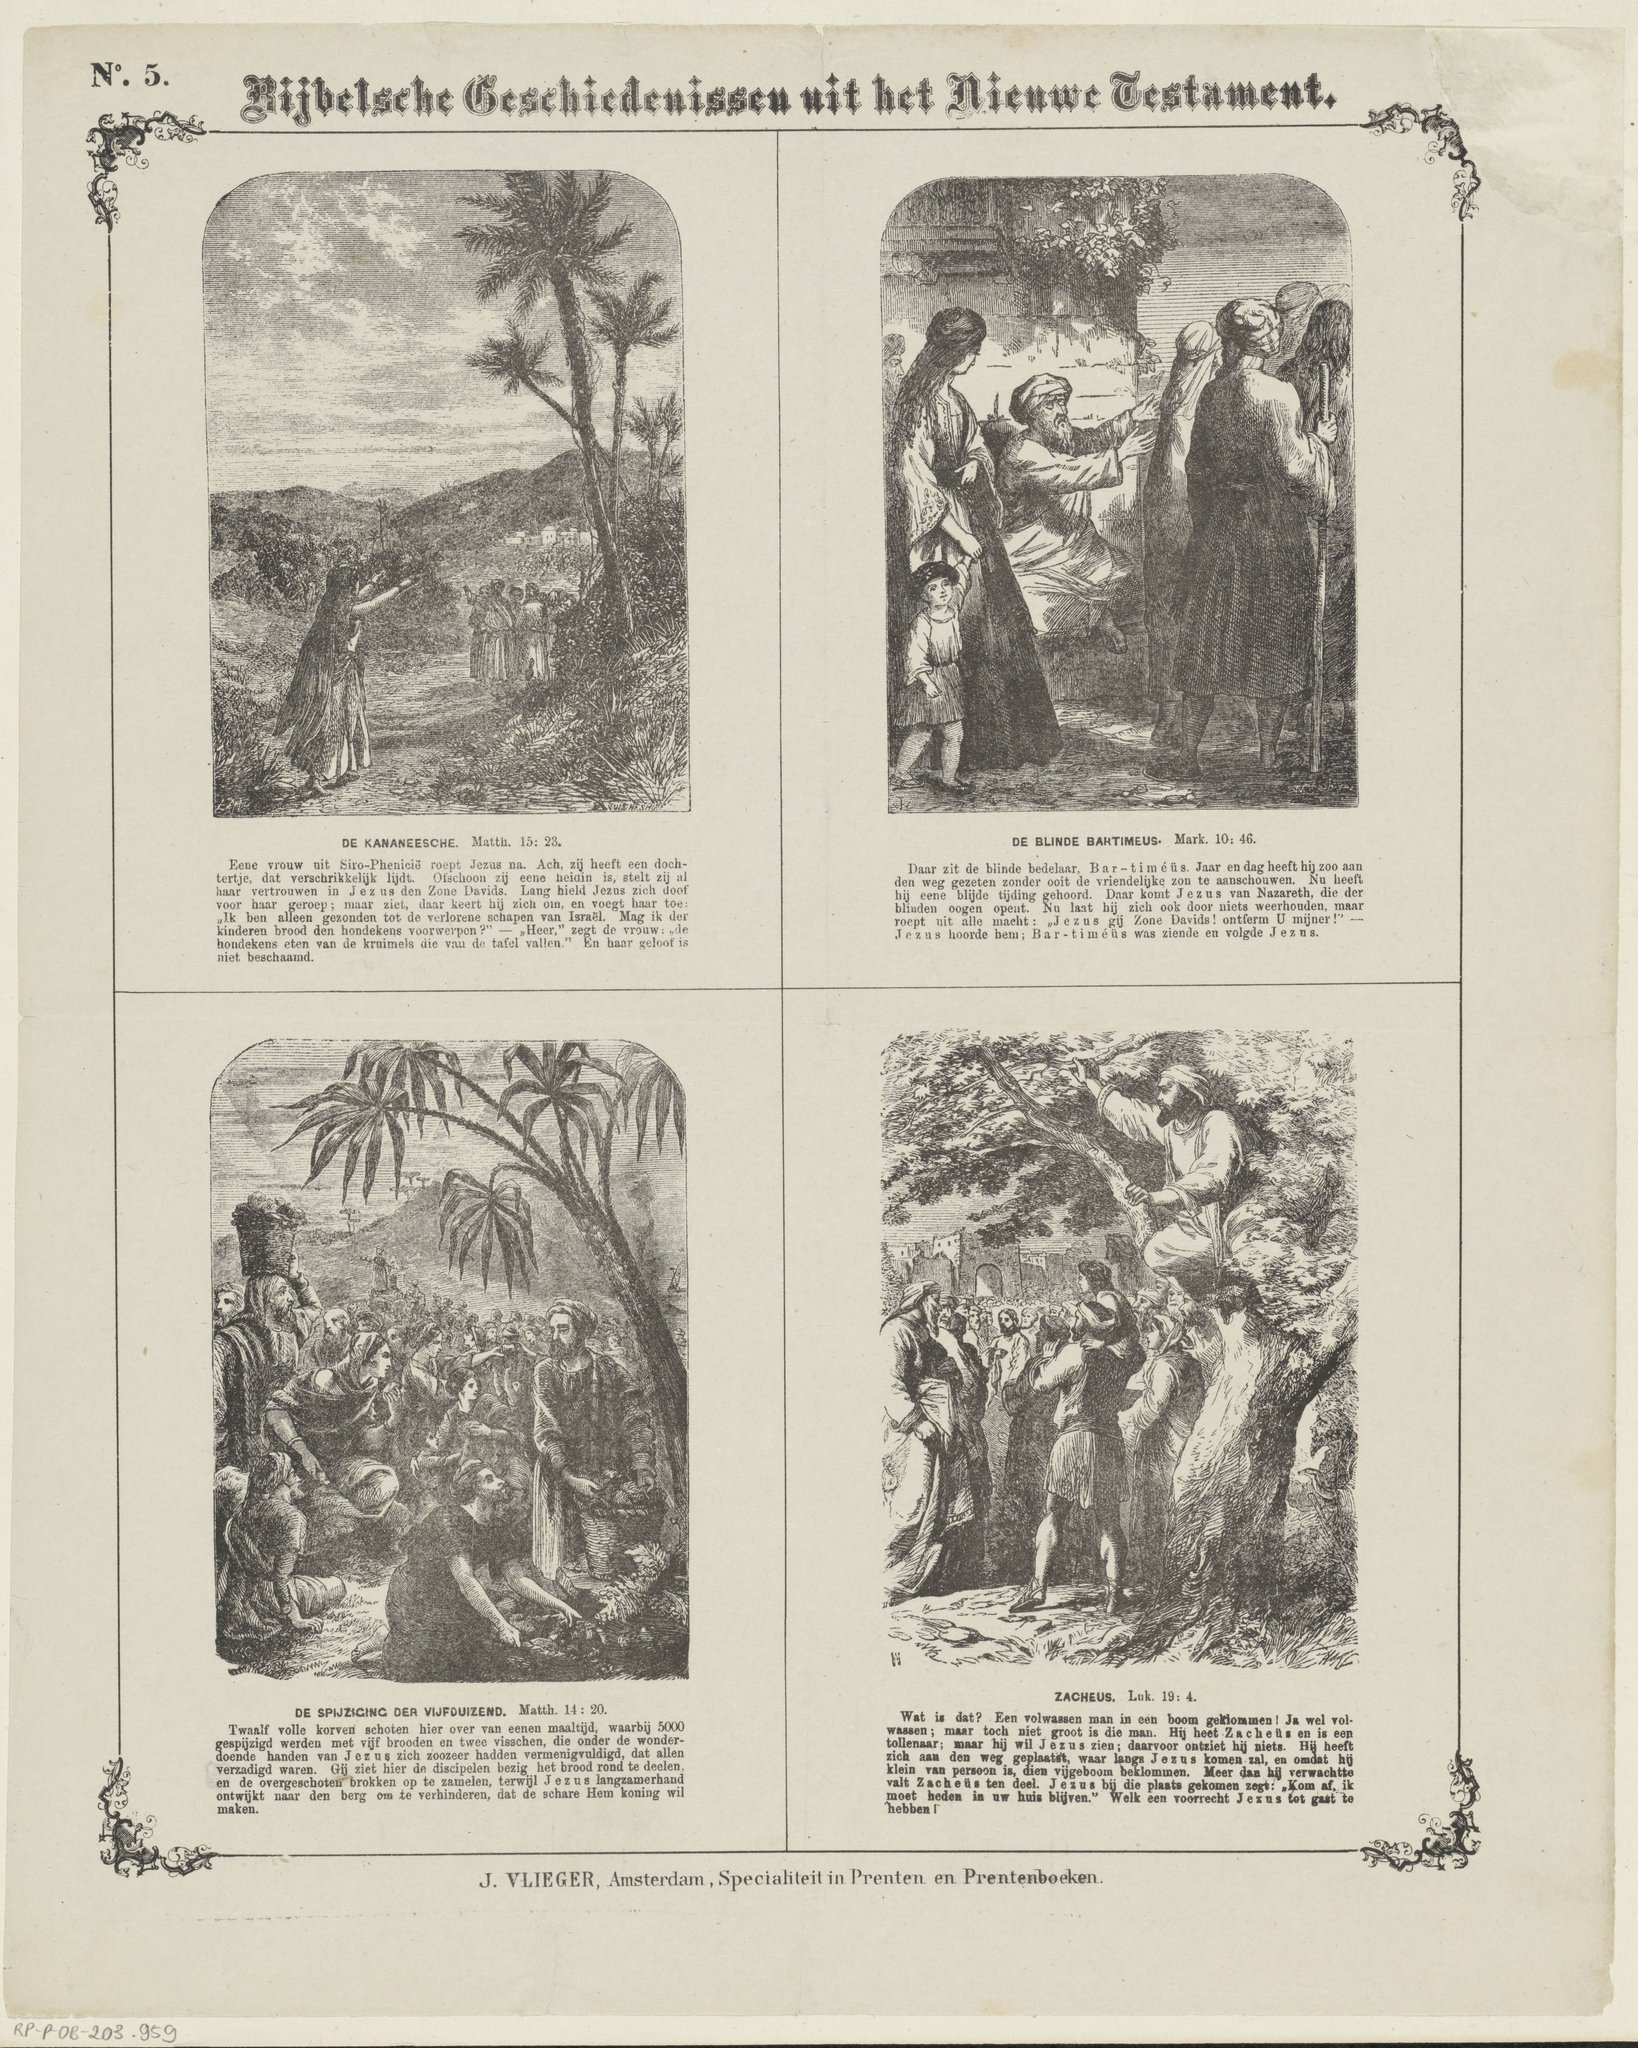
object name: print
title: Bijbelsche geschiedenissen uit het Nieuwe Testament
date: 1871-1908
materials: paper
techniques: letterpress printing, engraving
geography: amsterdam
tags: multiplication of loaves and fishes for a multitude of four or five thousand people (matthew 14:13-21, 15:32-39; mark 6:32-44, 8:1-10; luke 9:10-17; john 6:1-14), a canaanite woman kneels before christ, asking him to heal her daughter; the metaphor of the dogs and bread (matthew 15:21-28; mark 7:24-30), calling of zacchaeus, who is sitting in a fig-tree (christ passing through jericho), healing of two blind men, or one (bartimaeus), sitting near jericho (matthew 20:29-34; mark 10:46-52; luke 18:35-43), new testament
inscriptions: collector's mark: Lugt 2760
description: Blad met 4 voorstellingen van verhalen uit het Nieuwe Testament. De Kananeesche vrouw, de blinde Bartimeüs, de spijziging van vijfduizend en Zacheüs in een vijgenboom. Onder elke afbeelding de bijbehorende Bijbeltekst. Genummerd linksboven: No. 5.